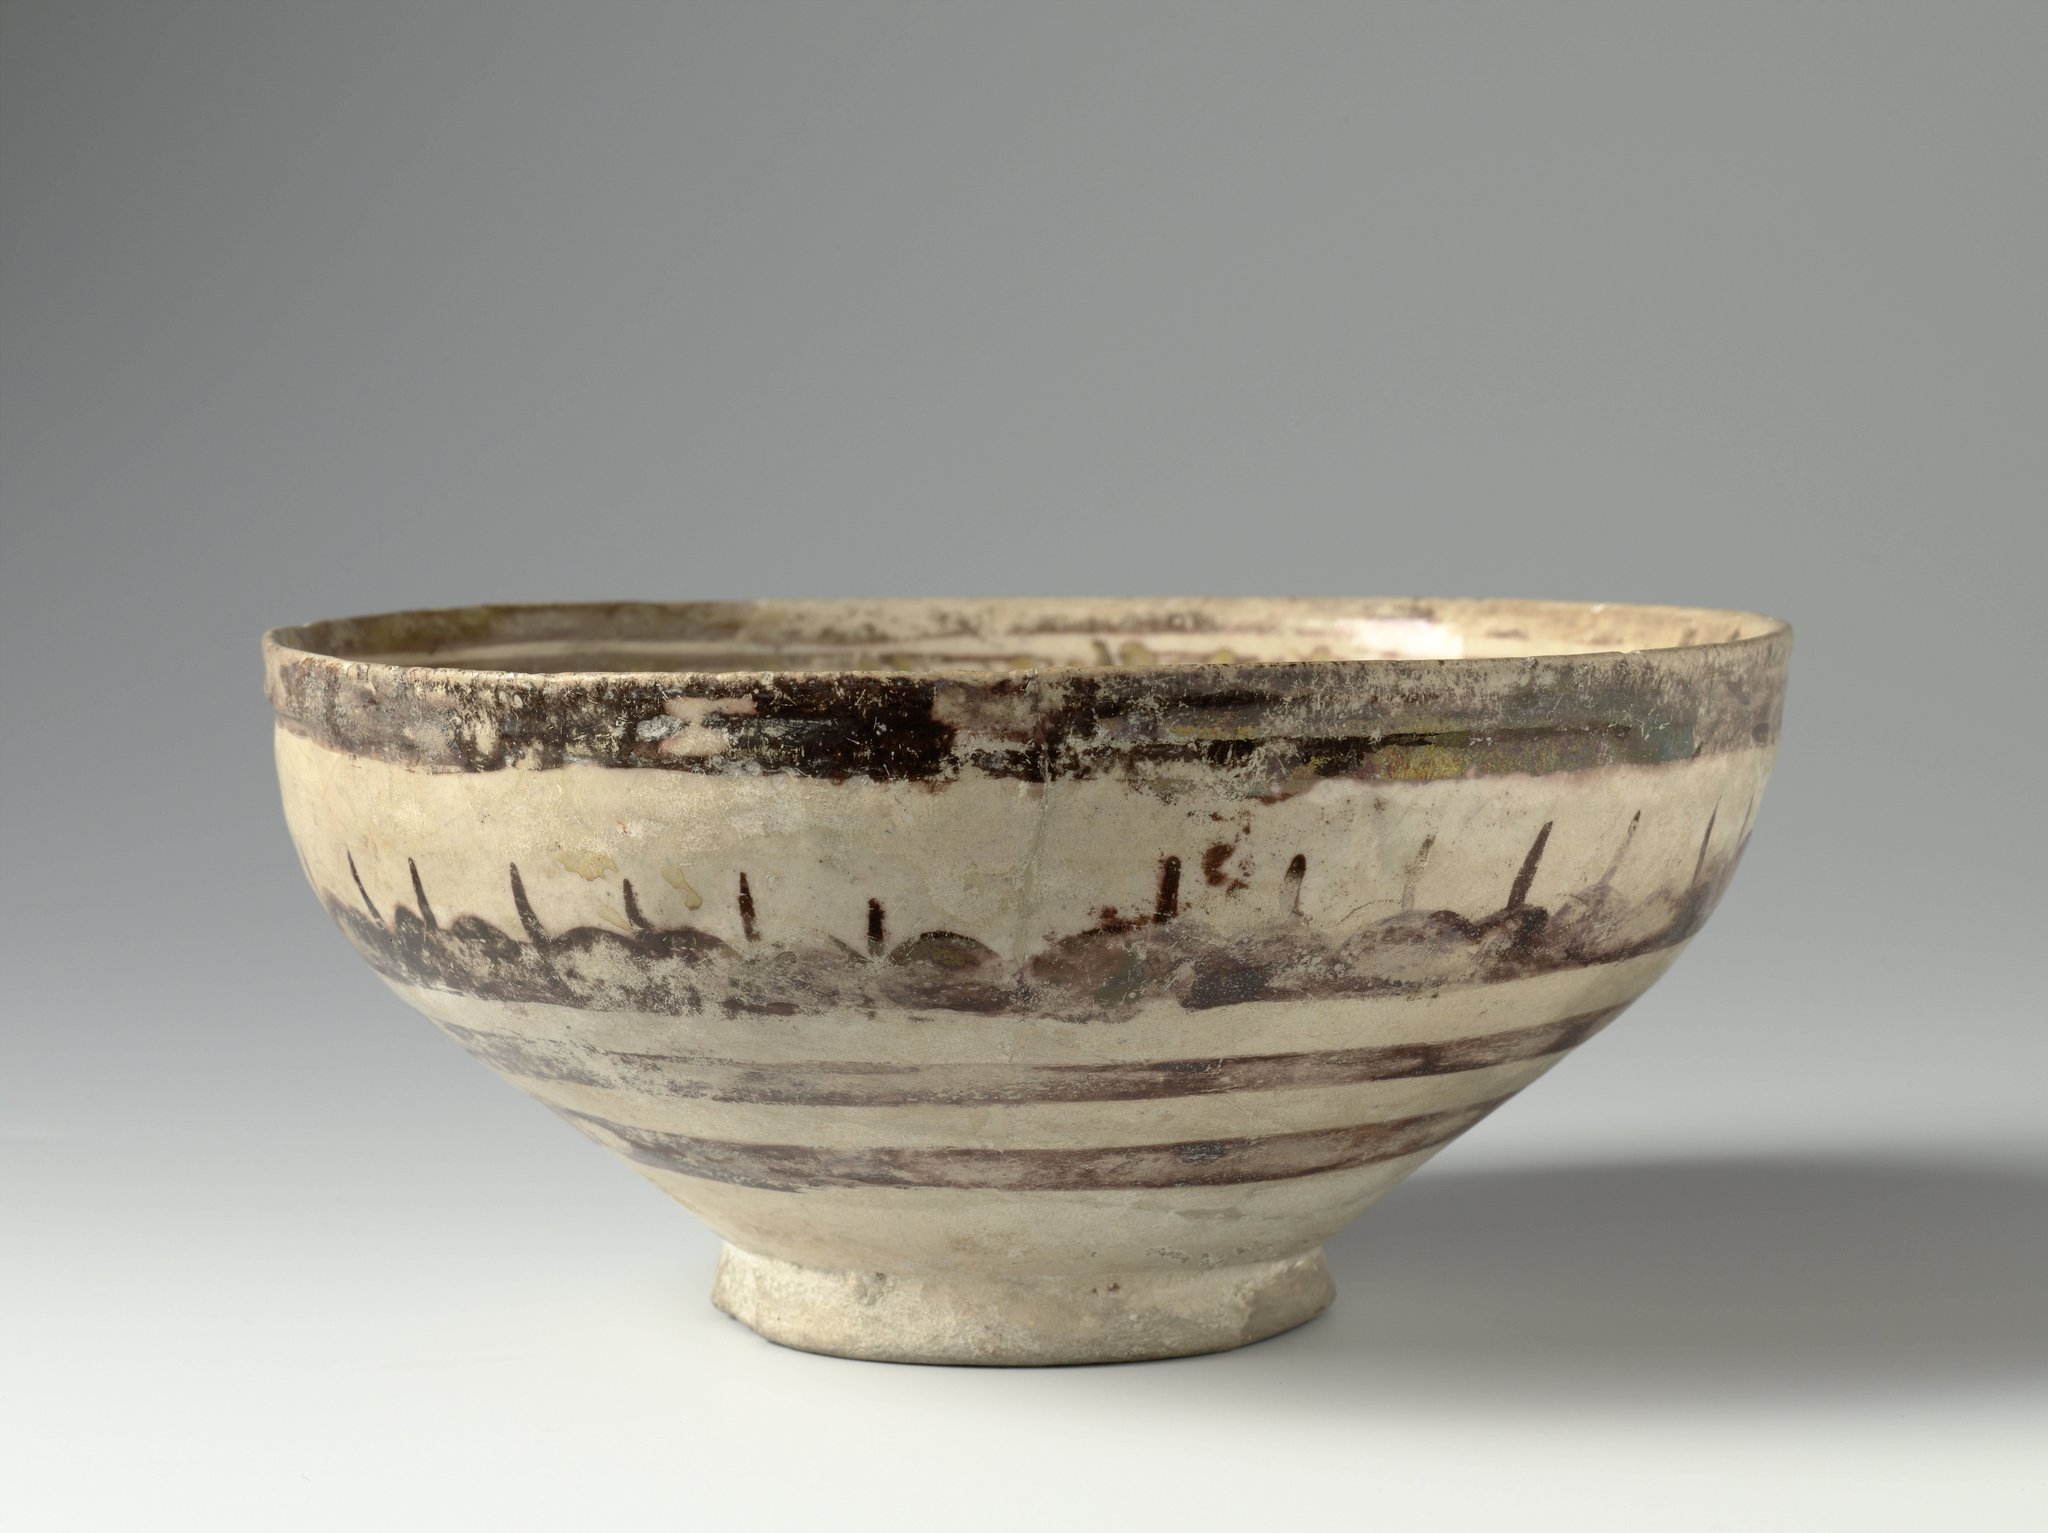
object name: bowl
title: Bowl with a horsemen and an inscription border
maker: Anonymous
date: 1200-1220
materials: earthenware, glaze, luster, paint, quartz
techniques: firing, turning, vitrification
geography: kashan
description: Kom van kwarts-fritgoed met een wit tin-lood-alkaliglazuur waarop een decor van luster. Op de bodem een medaillon met een ruiter. De binnenwand met een band met een (Arabisch) opschrift en een decoratieve band. De buitenwand met decoratieve banden.